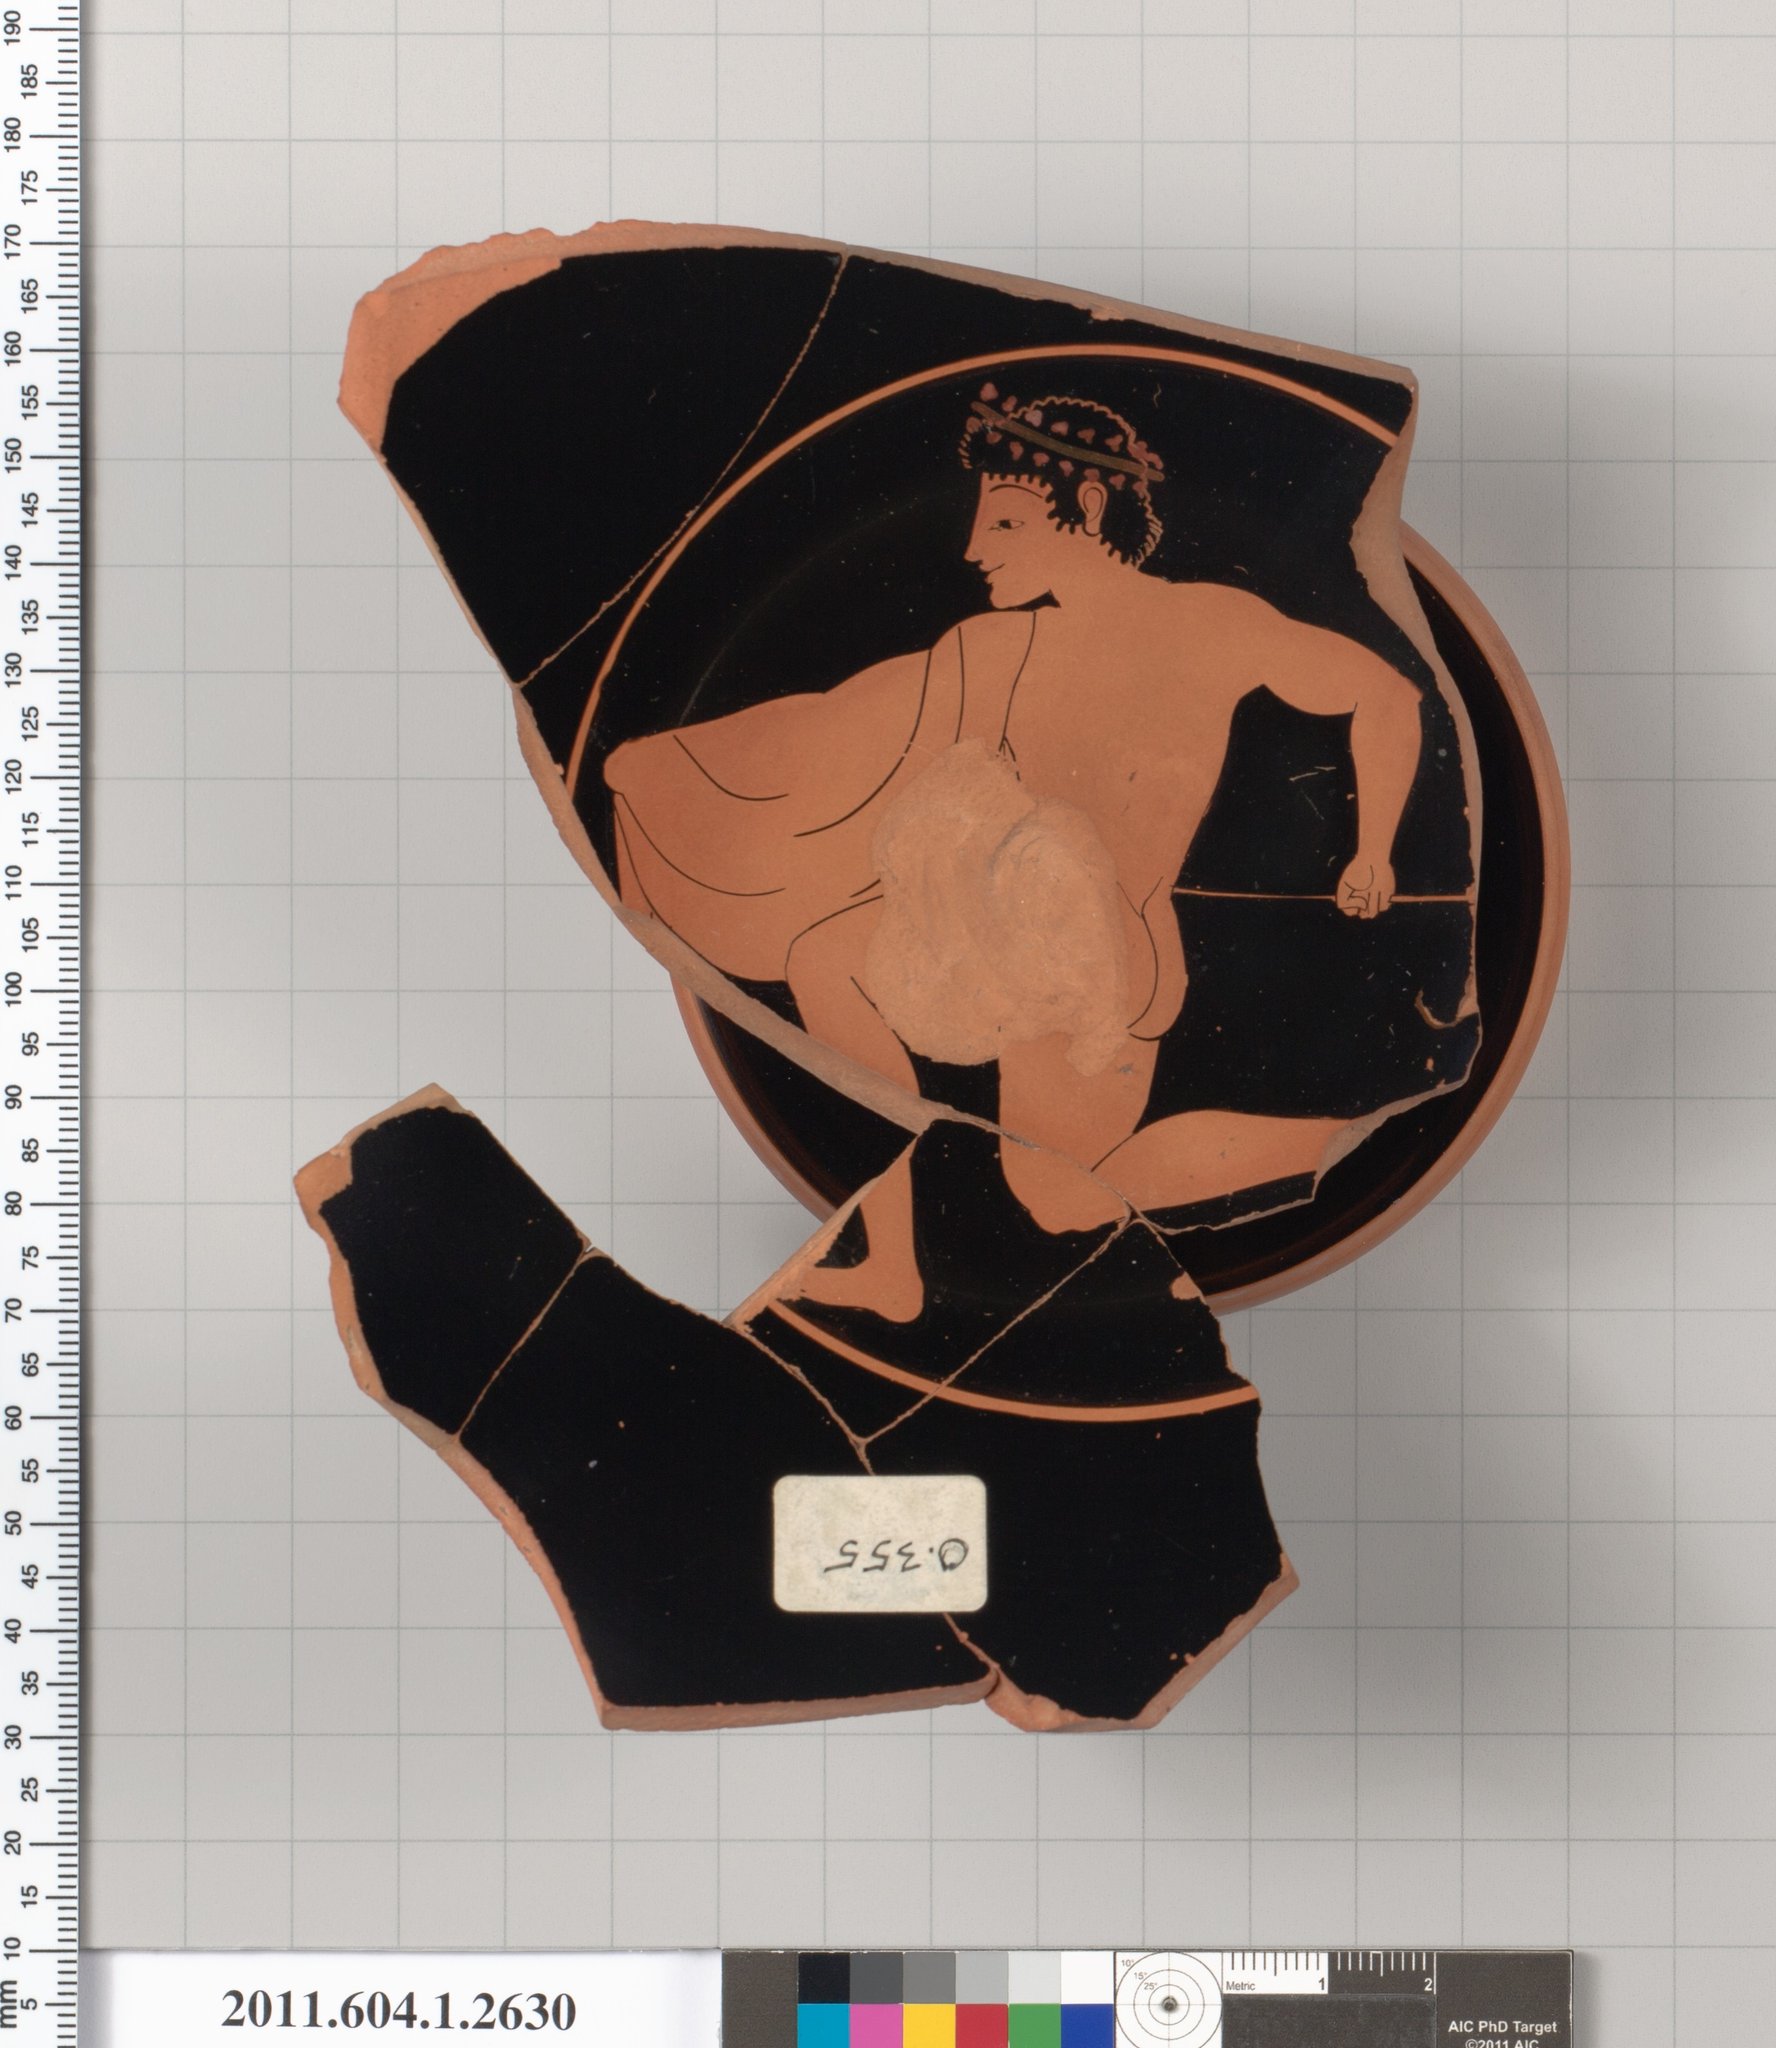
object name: kylix fragment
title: Terracotta fragment of a kylix (drinking cup)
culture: greek, attic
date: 520-500 BCE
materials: terracotta